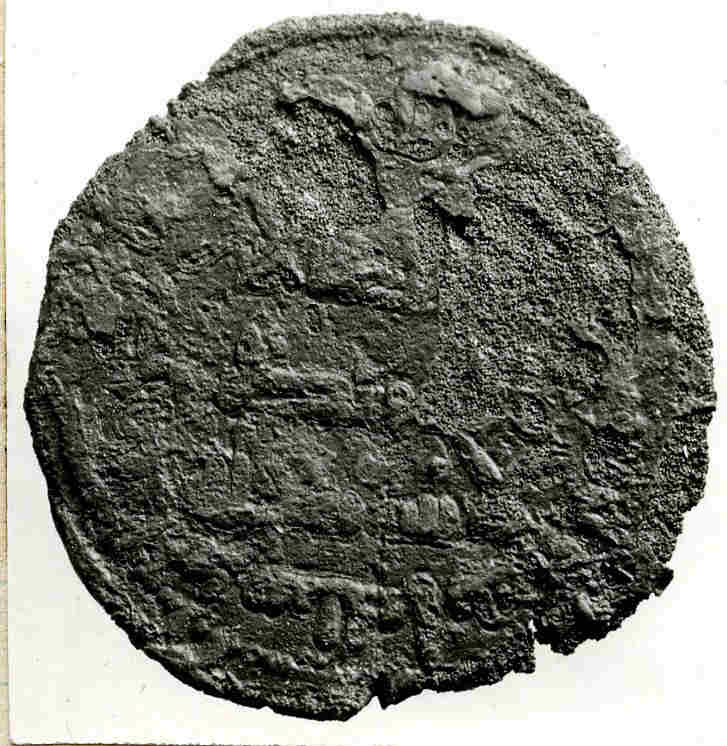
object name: coin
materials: copper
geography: iran